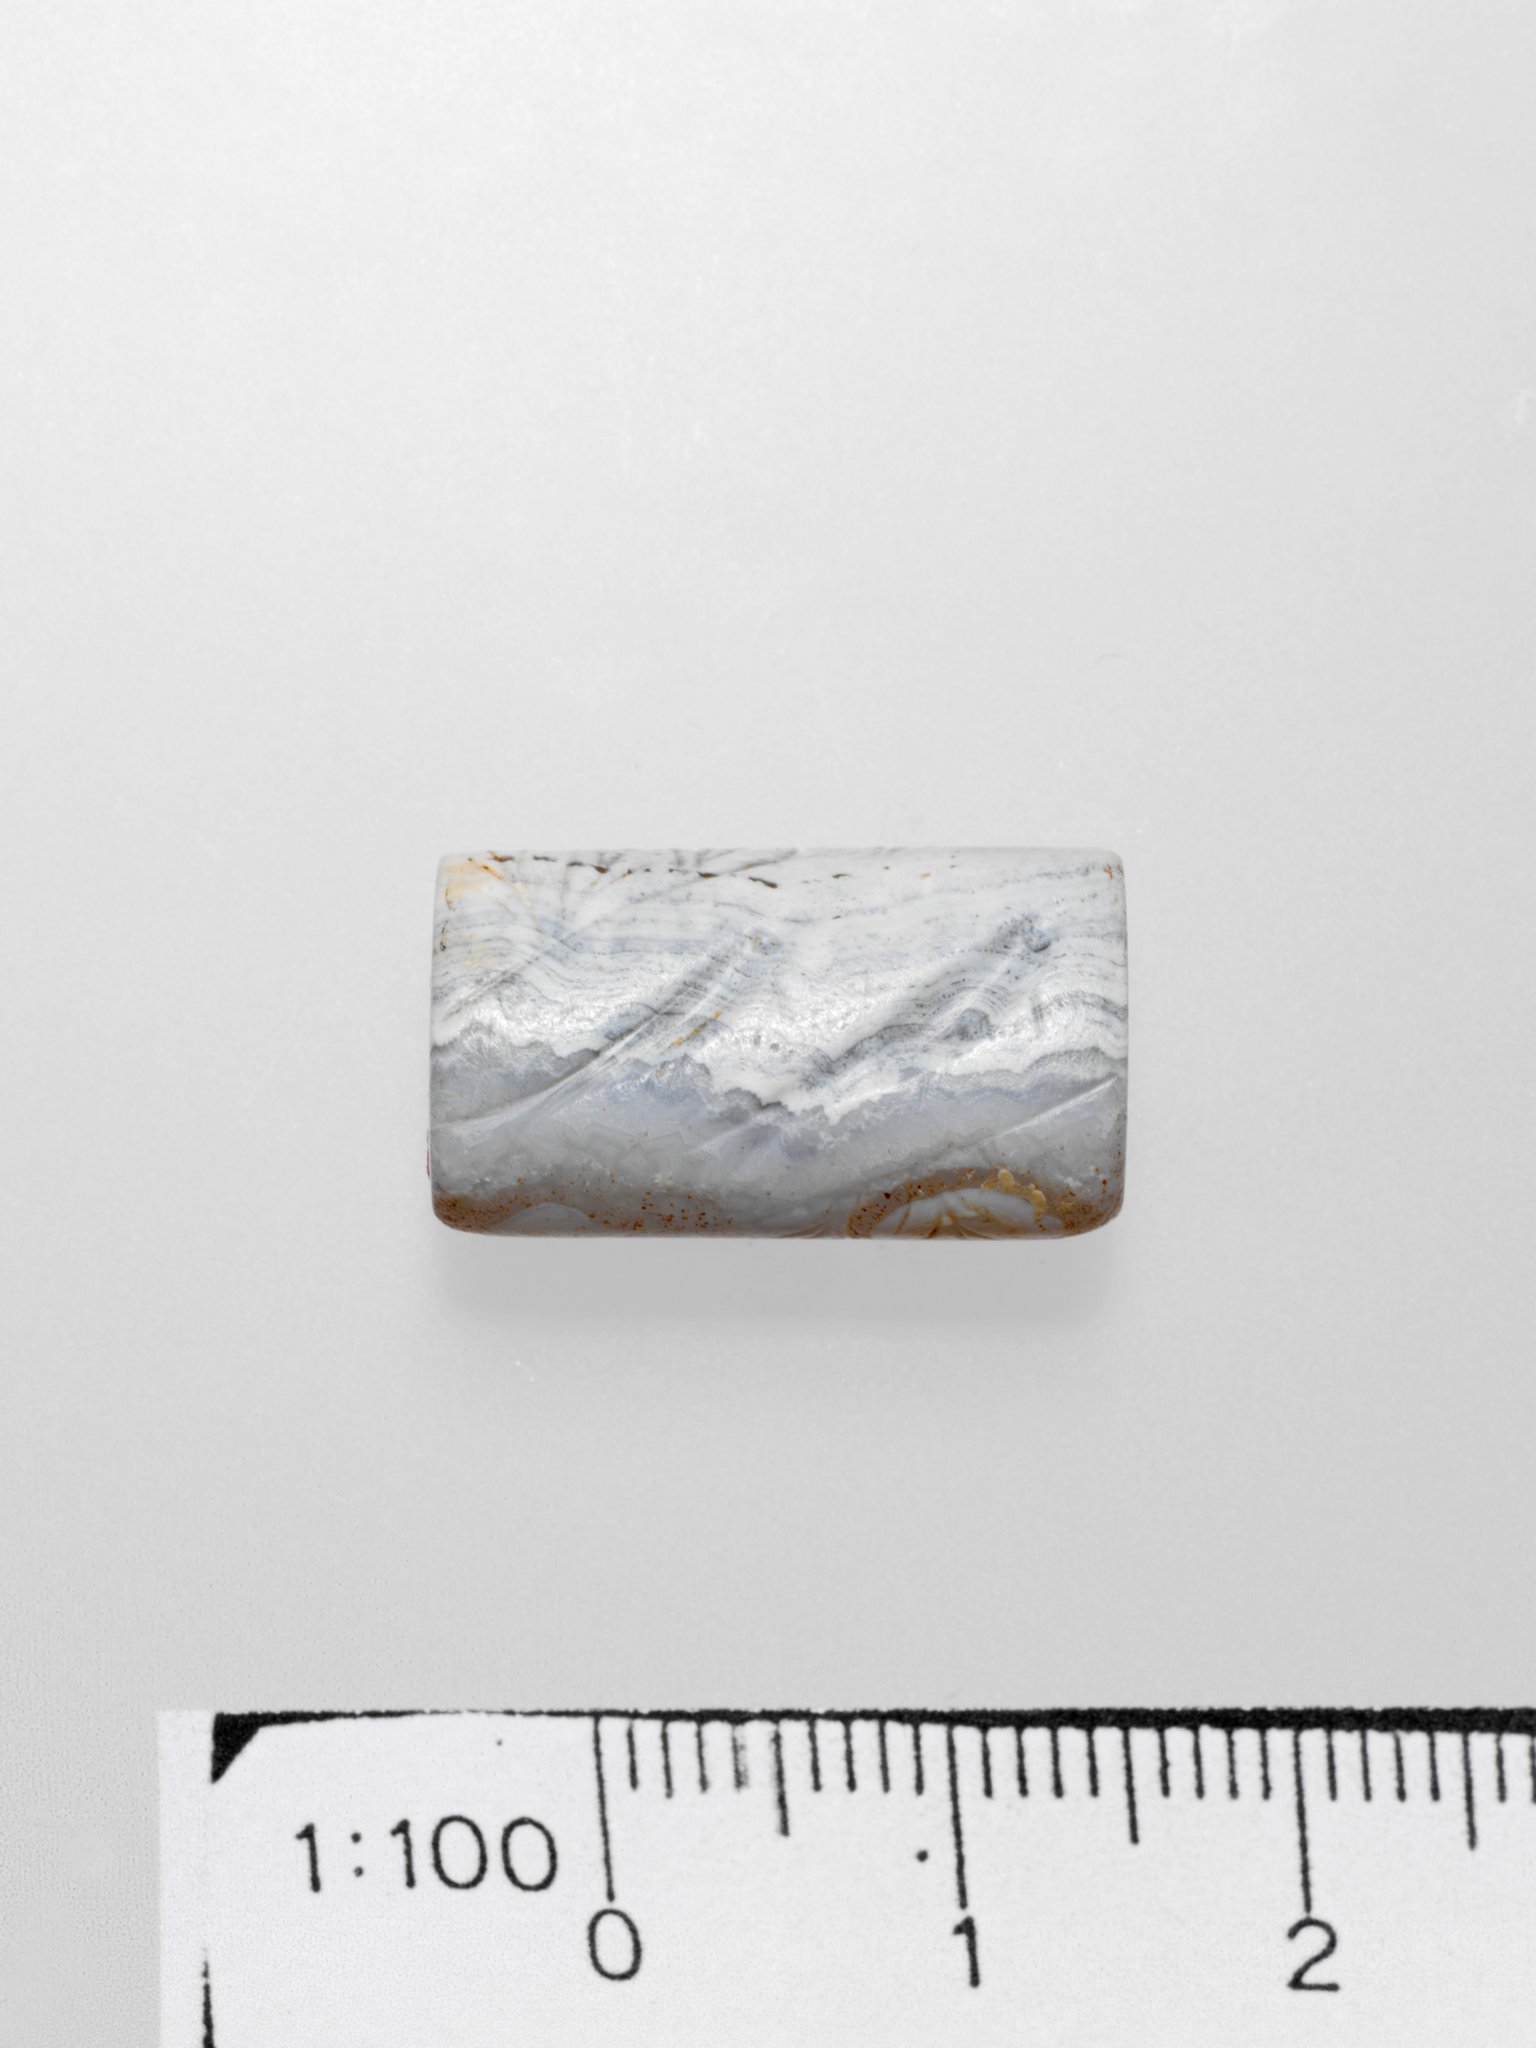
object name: seal, cylinder, flattened, two fish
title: Agate flattened cylinder seal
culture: minoan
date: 1750-1450 BCE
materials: stone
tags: fish